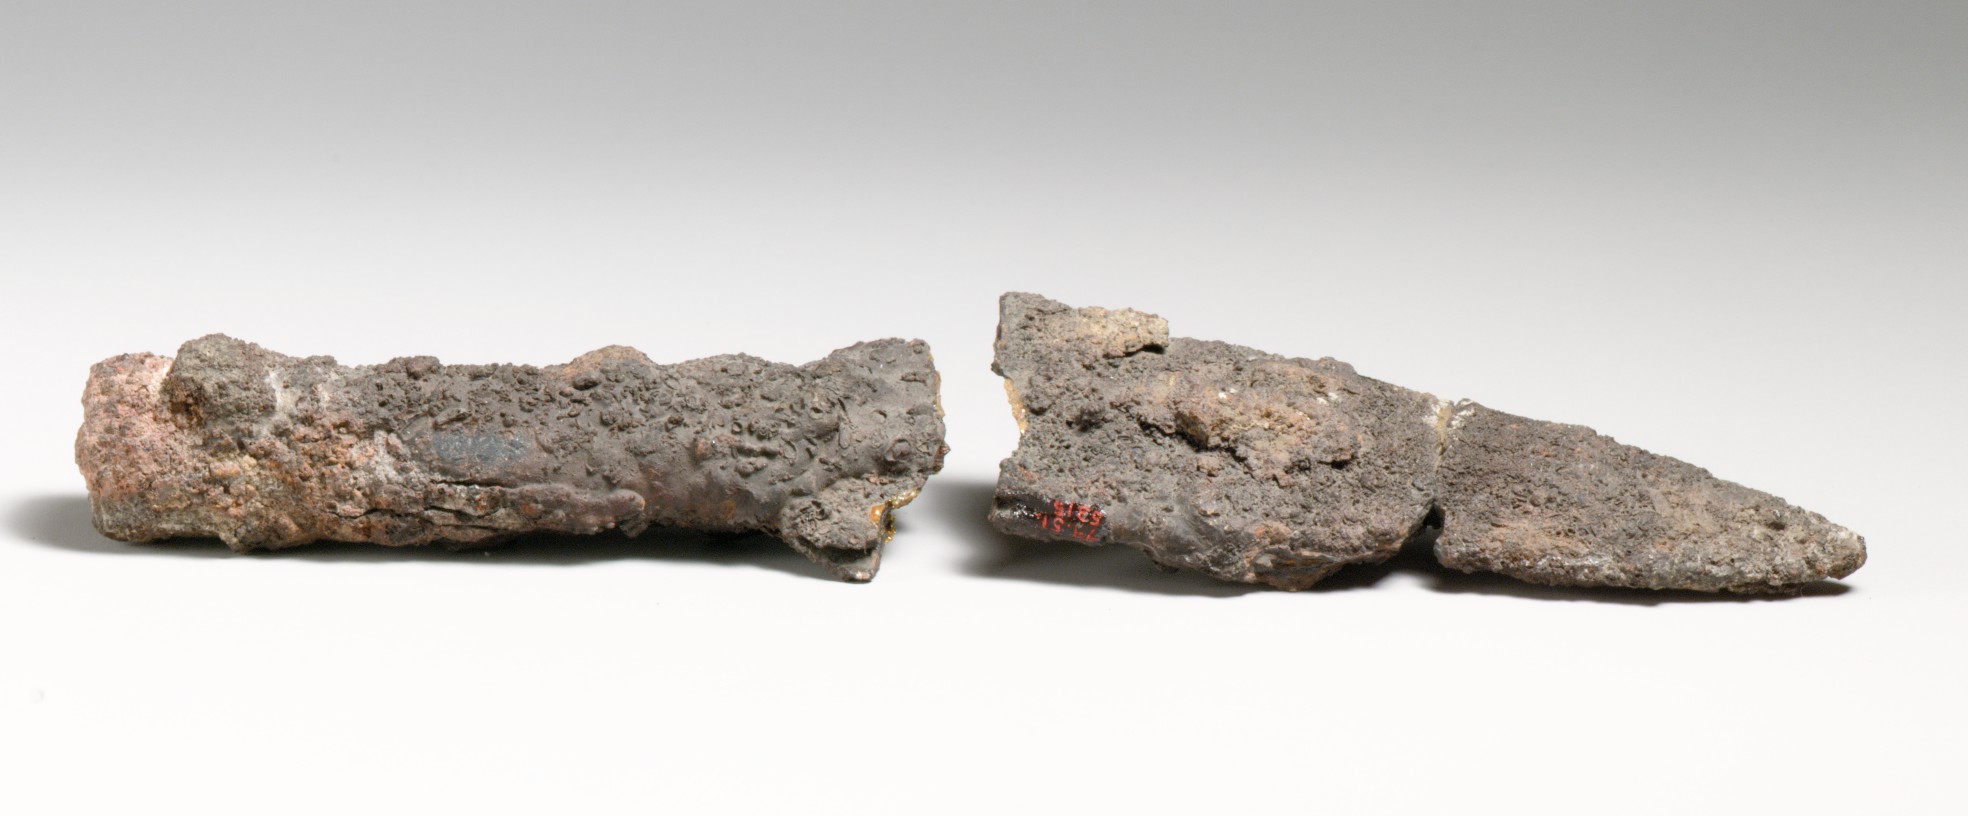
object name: spearhead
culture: cypriot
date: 1000-900 BCE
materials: iron